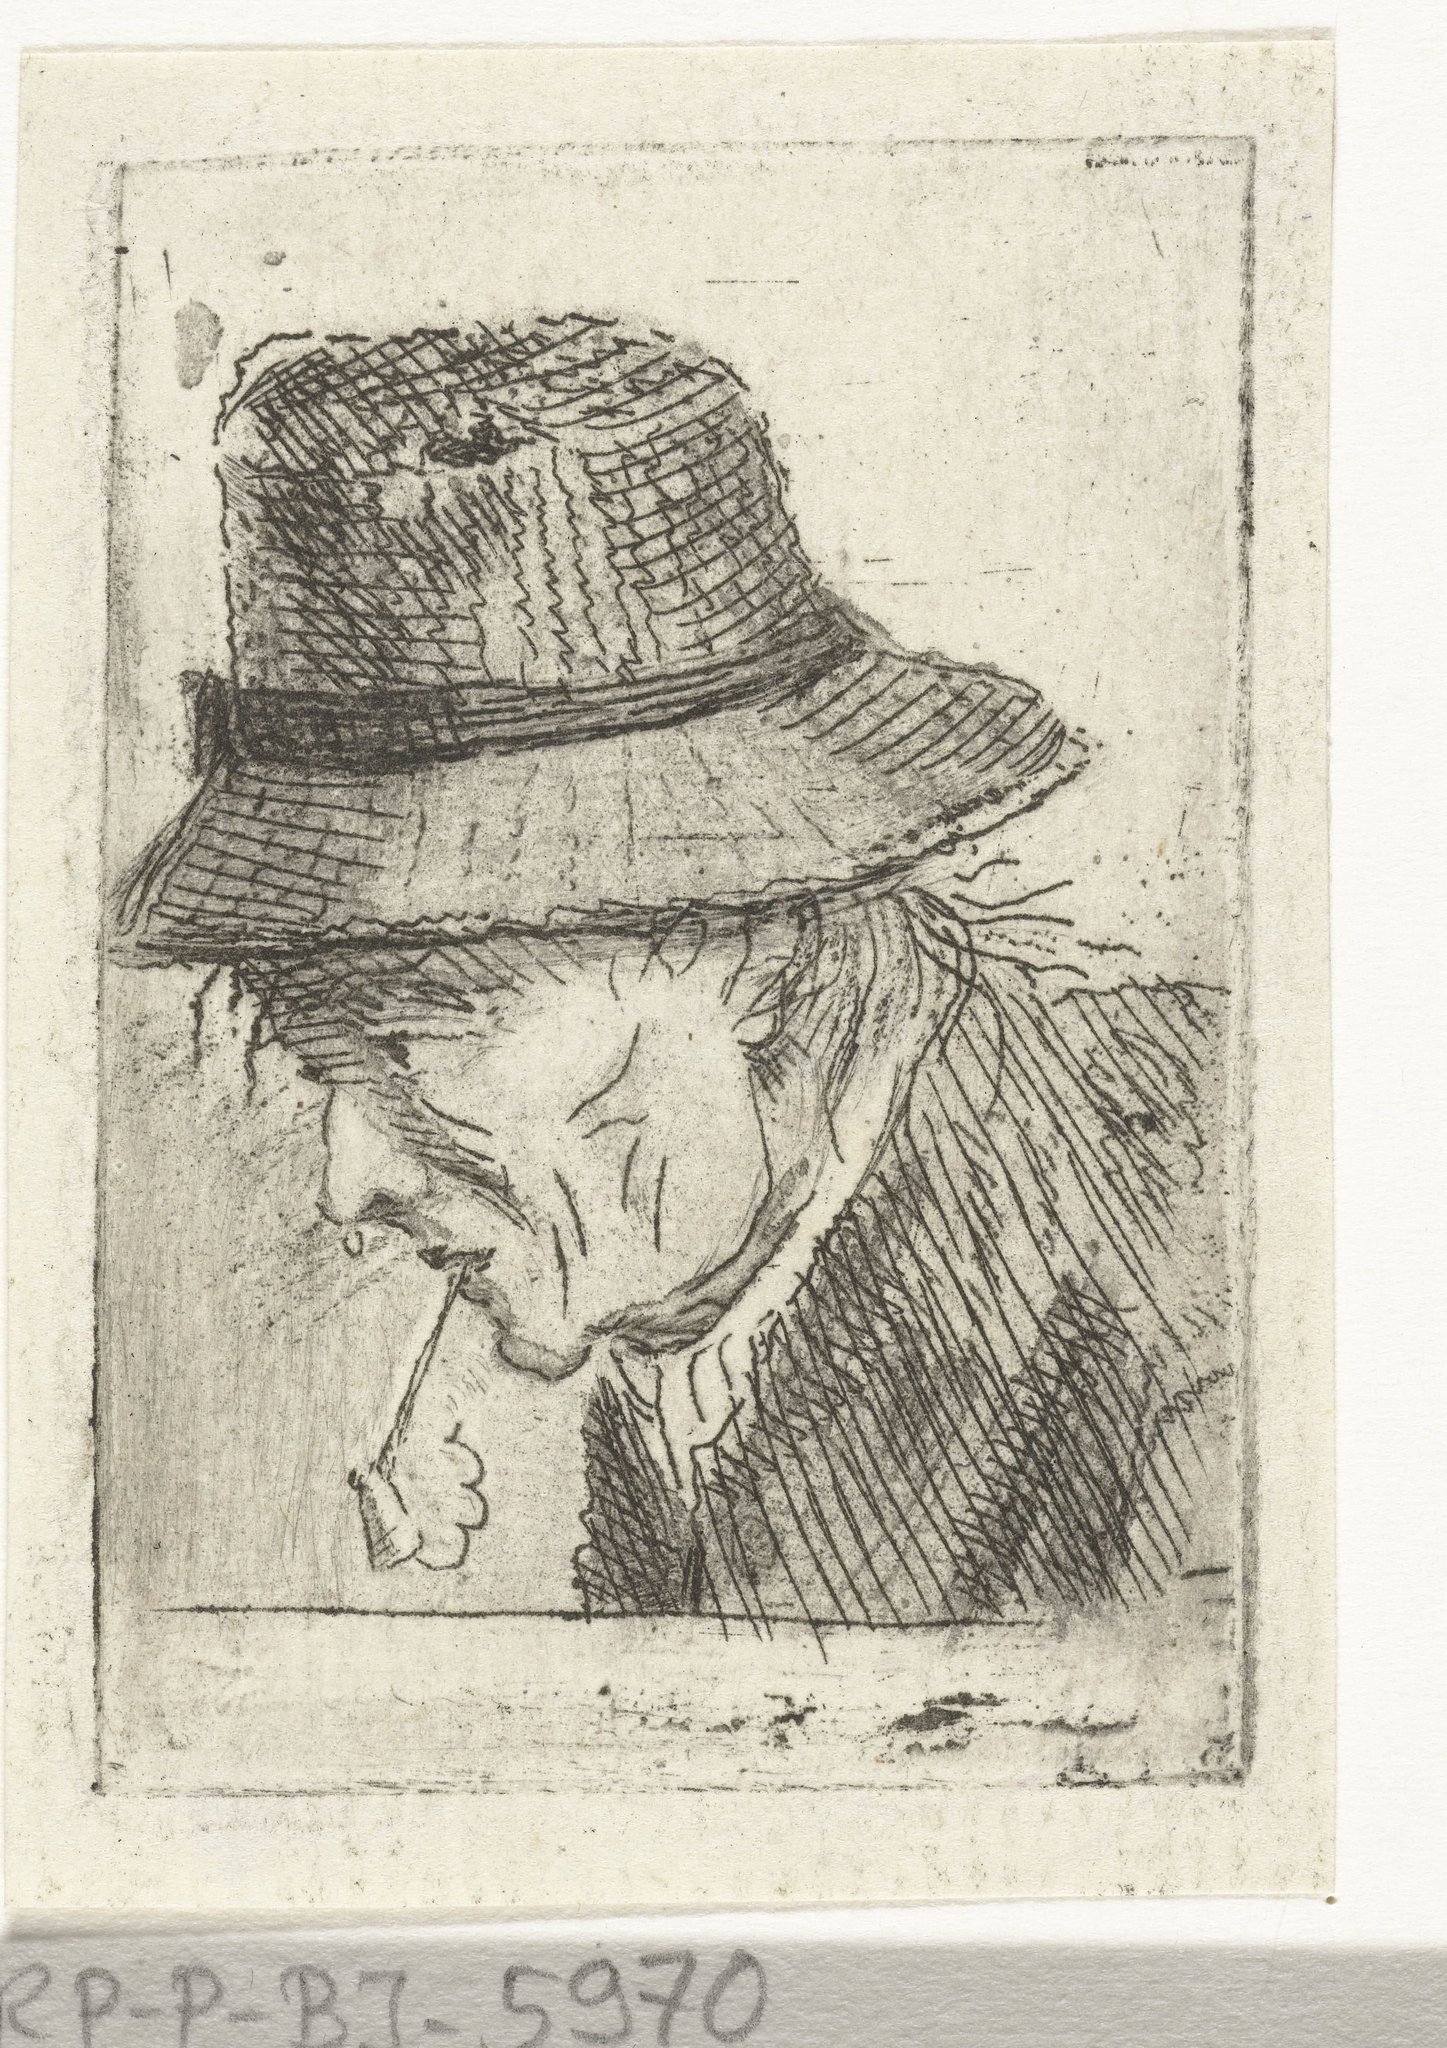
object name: print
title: Manshoofd met hoed en pijp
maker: louis bernard coclers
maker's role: draughtsman, print maker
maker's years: 1741-1817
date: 1756-1817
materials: paper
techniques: aquatint, drypoint, etching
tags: head-gear: hat (+ men's clothes), pipe ~ tobacco (+ taking (particular) foodstuffs: eating, drinking, smoking, chewing, etc.)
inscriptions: collector's mark: Lugt 240